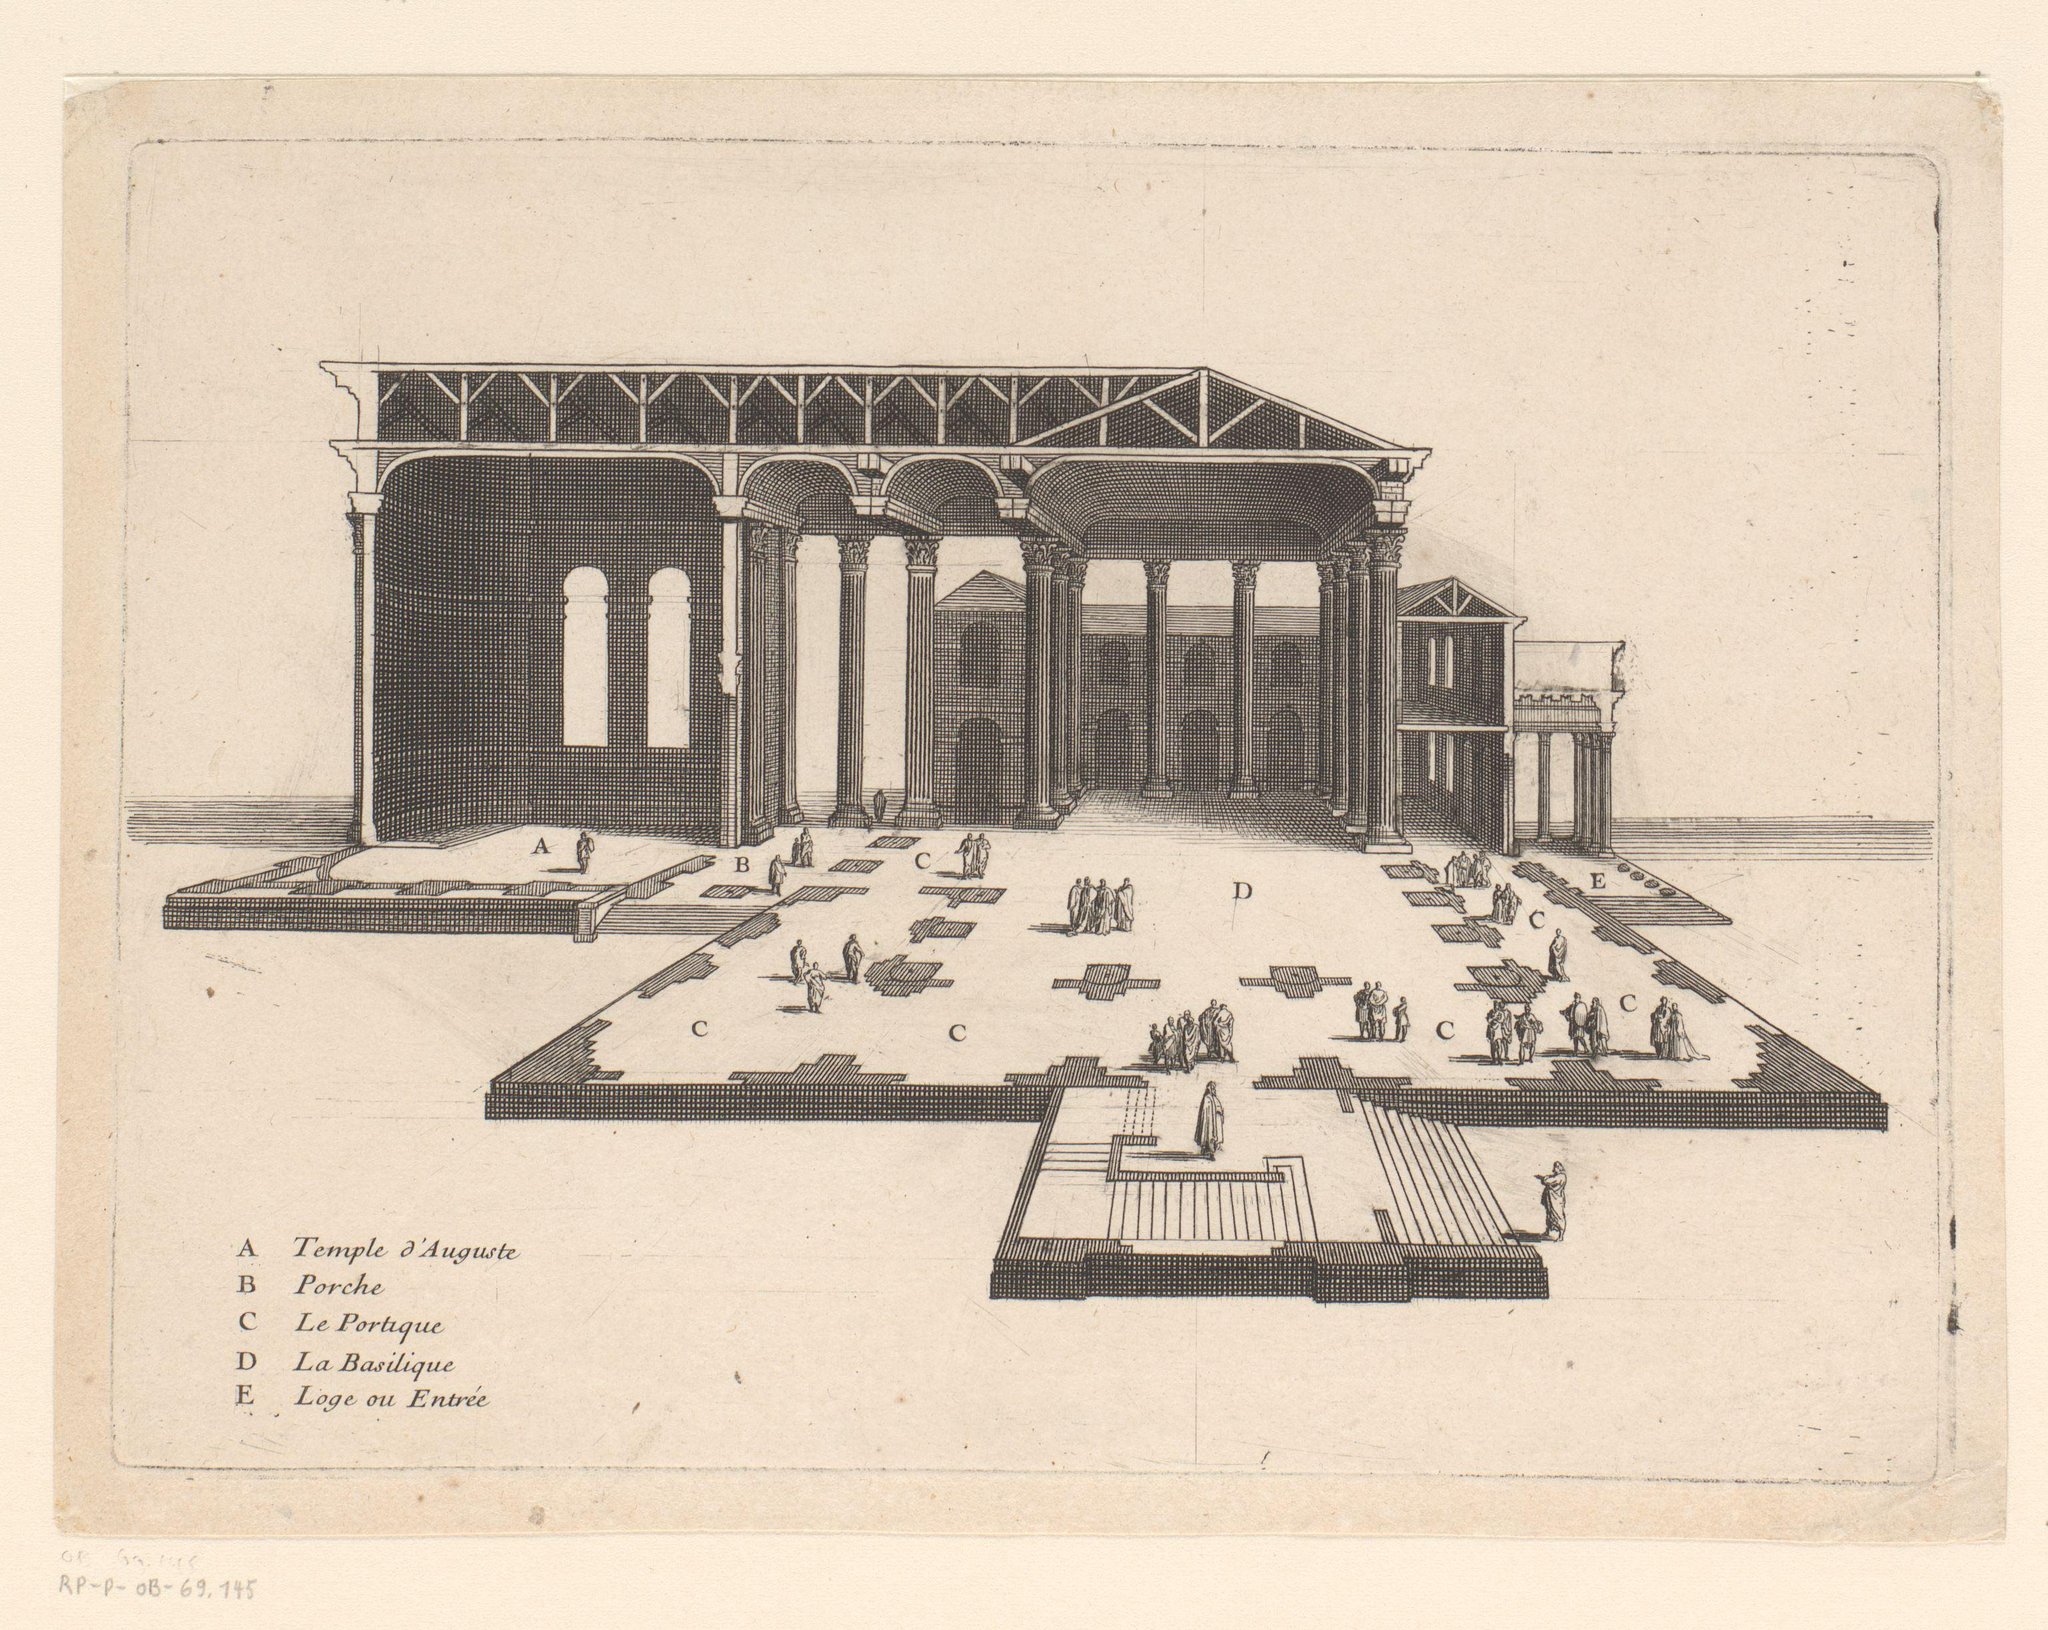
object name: print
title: Doorsnede van de tempel van Augustus in Rome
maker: sébastien leclerc (i)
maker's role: print maker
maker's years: 1637-1714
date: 1647-1714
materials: paper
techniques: etching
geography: france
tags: temple, shrine ~ roman religion